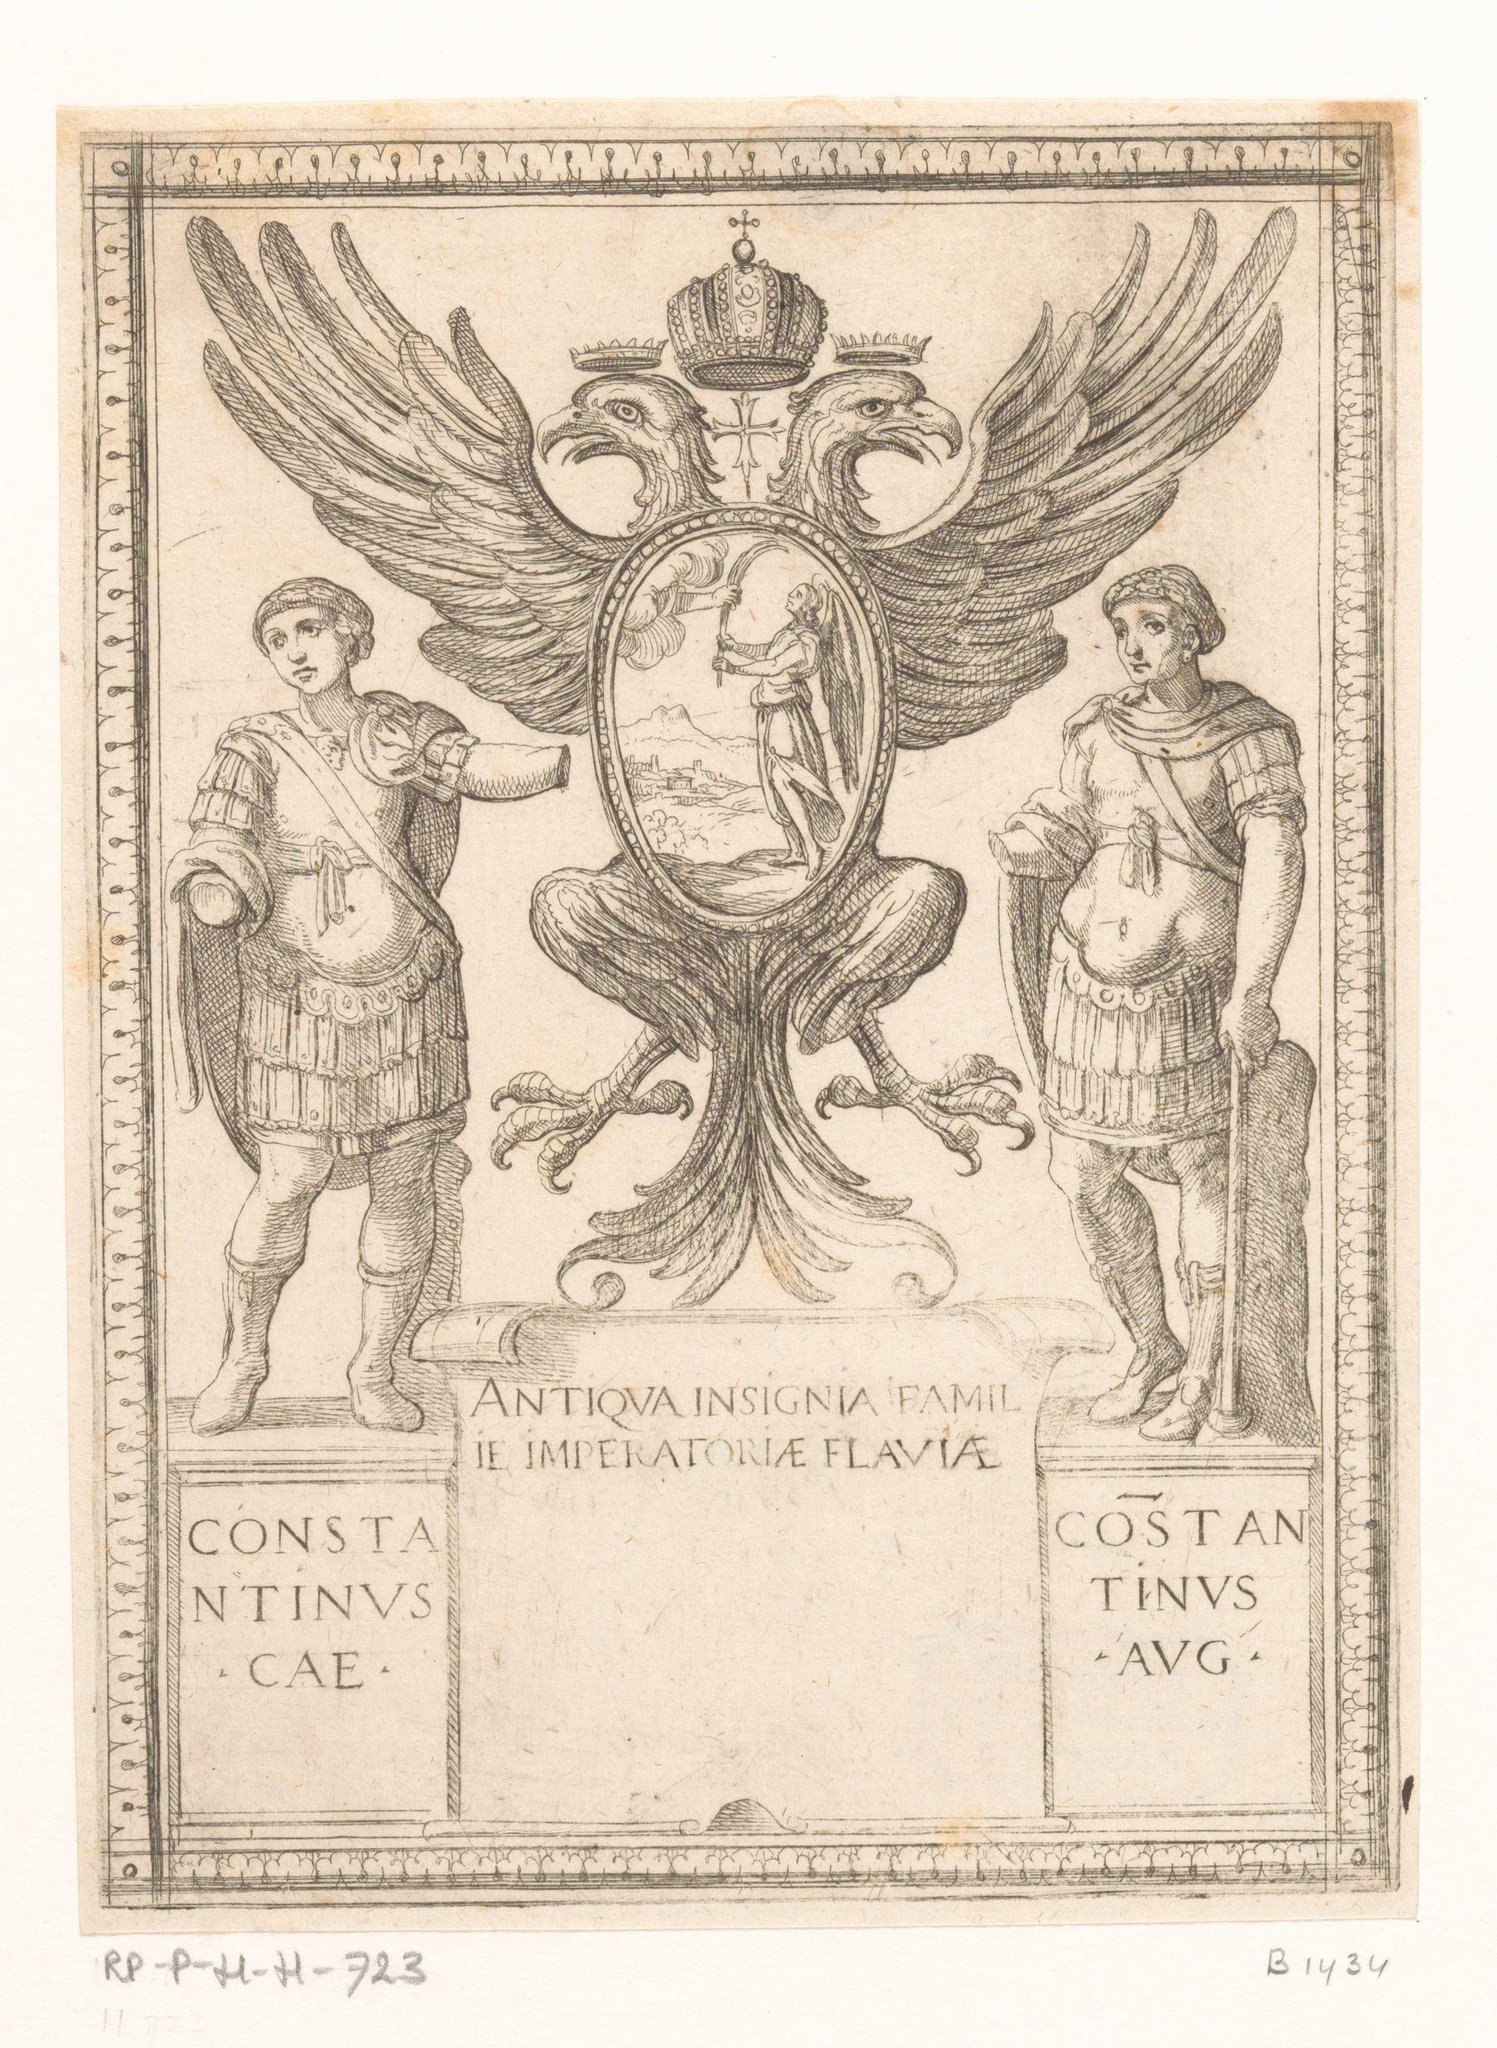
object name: print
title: Geschiedenis van de Orde van de heilige Joris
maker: antonio tempesta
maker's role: draughtsman, painter, print maker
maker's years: 1555-1630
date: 1565-1630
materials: paper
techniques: etching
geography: italy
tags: coat of arms (symbol of sovereignty), historical persons, piece of sculpture, reproduction of a piece of sculpture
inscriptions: collector's mark: ‘Hinloopen’, collector's mark: Lugt 11, number: ‘1’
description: Het familiewapen van de Flaviërs wordt aan weerszijden geflankeerd door een sculptuur van keizer Constantijn de Grote. Opschriften in het Latijn op de basementen.